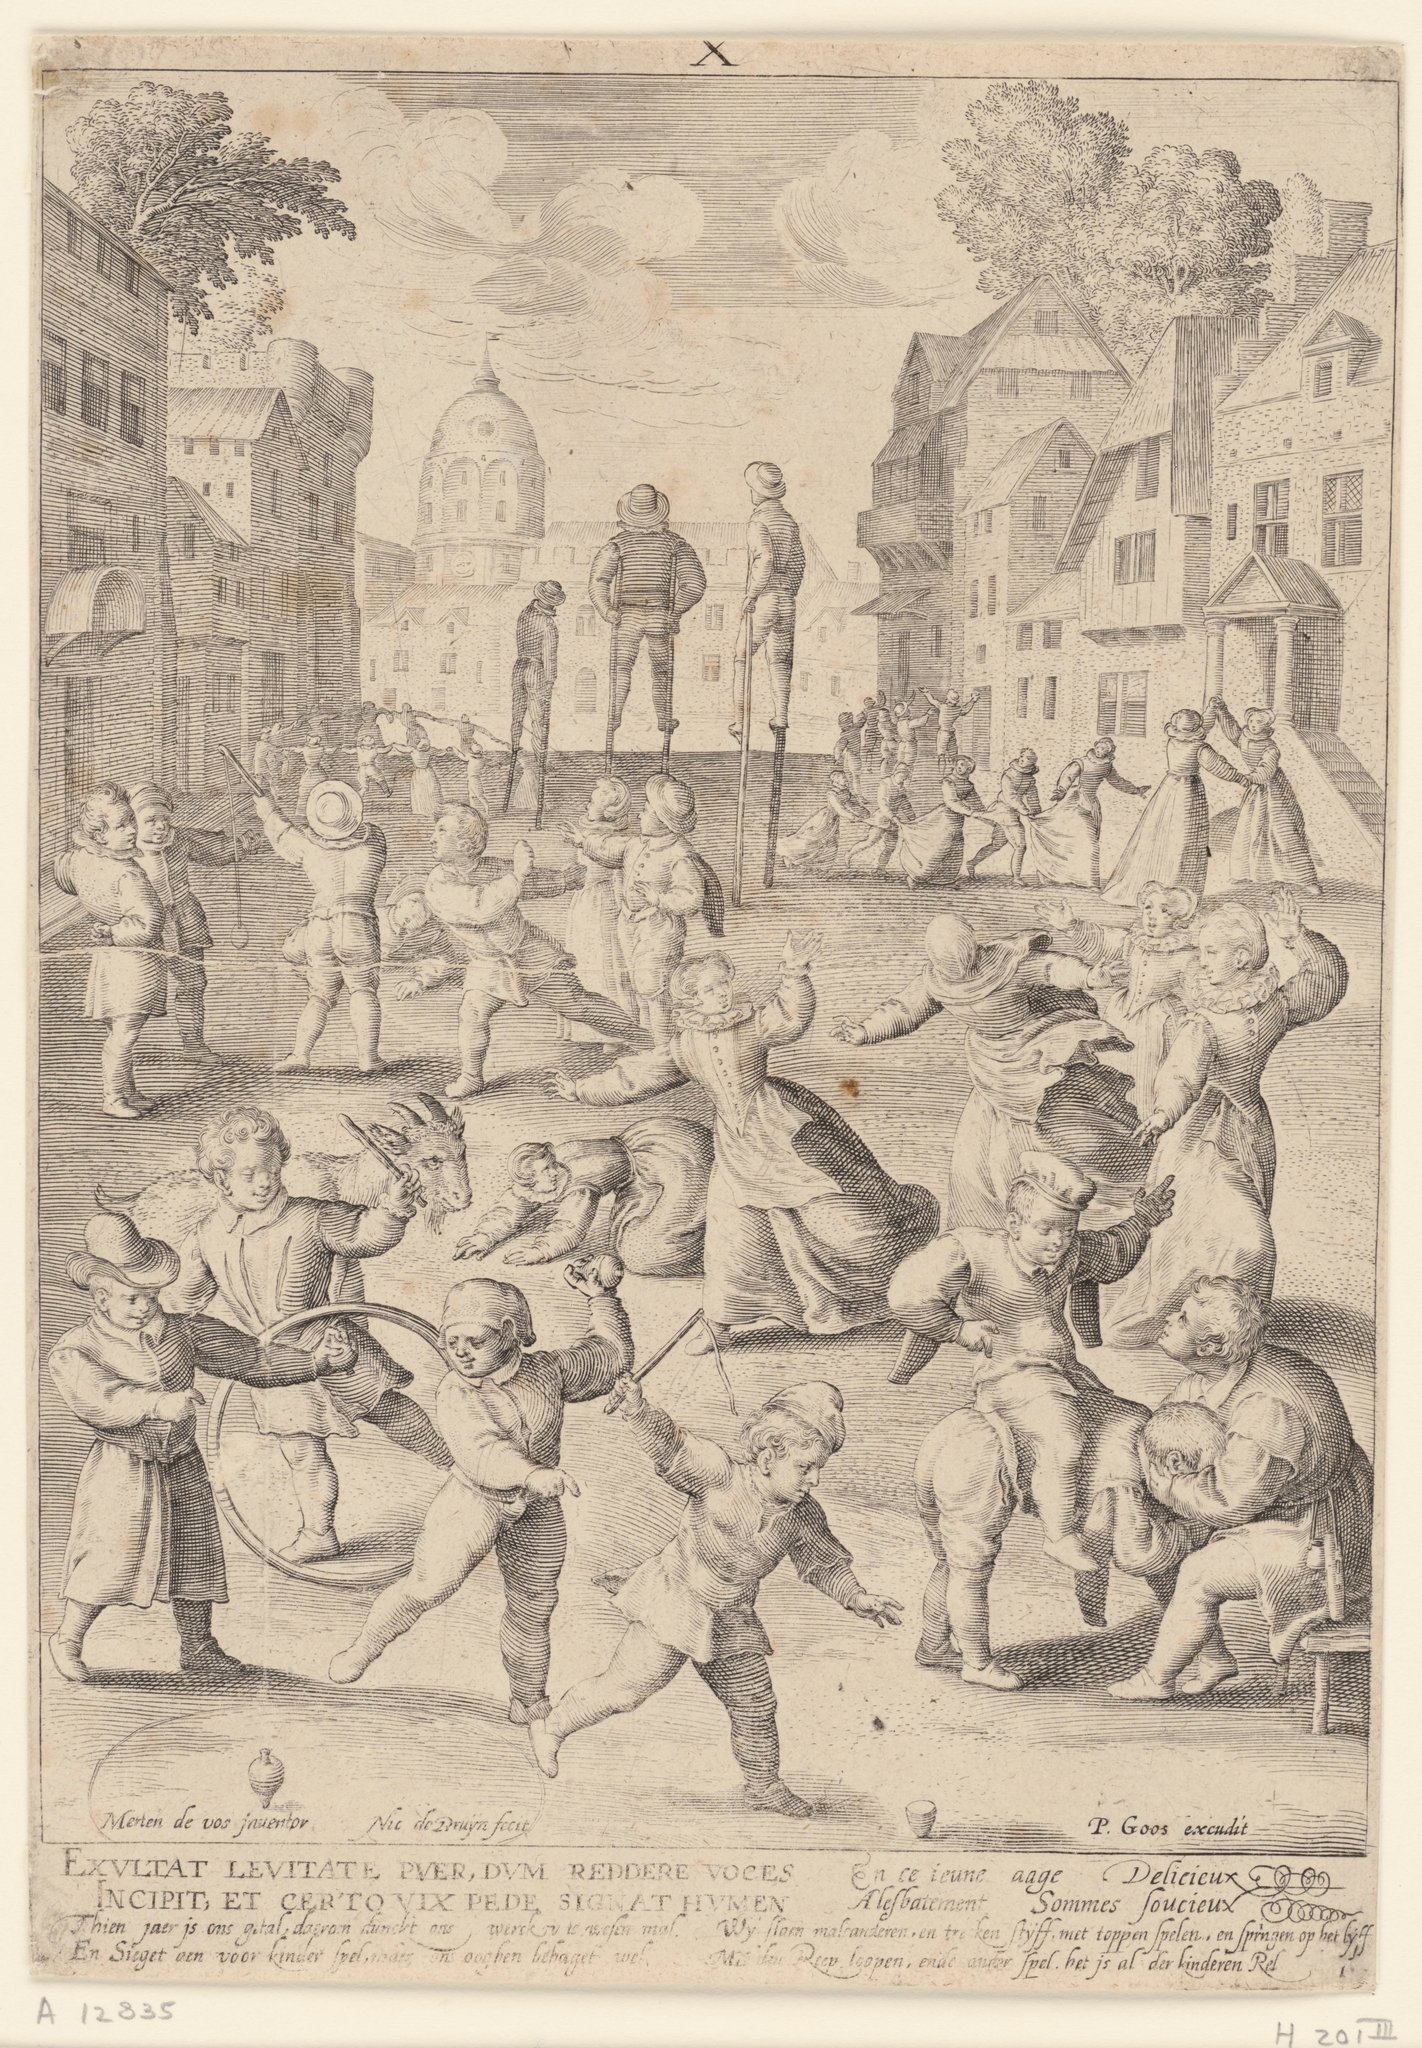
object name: print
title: Tien levensfasen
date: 1598-1602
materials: paper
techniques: engraving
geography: netherlands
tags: children's games and plays, (bowling a) hoop, the first years ~ the ages of man, (playing with) top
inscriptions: collector's mark: Lugt 2228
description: Prent naar ontwerp van Maerten de Vos. Prent uit serie van tien prenten met de tien levensfasen. Deze staat wordt niet beschreven bij Hollstein (Maerten de Vos), wel noemt De Hoop Scheffer drie verschillende uitgaven, van Pieter Goes als de tweede, maar deze prent is blijkbaar niet opgemerkt als een andere staat onder nr. 1466.